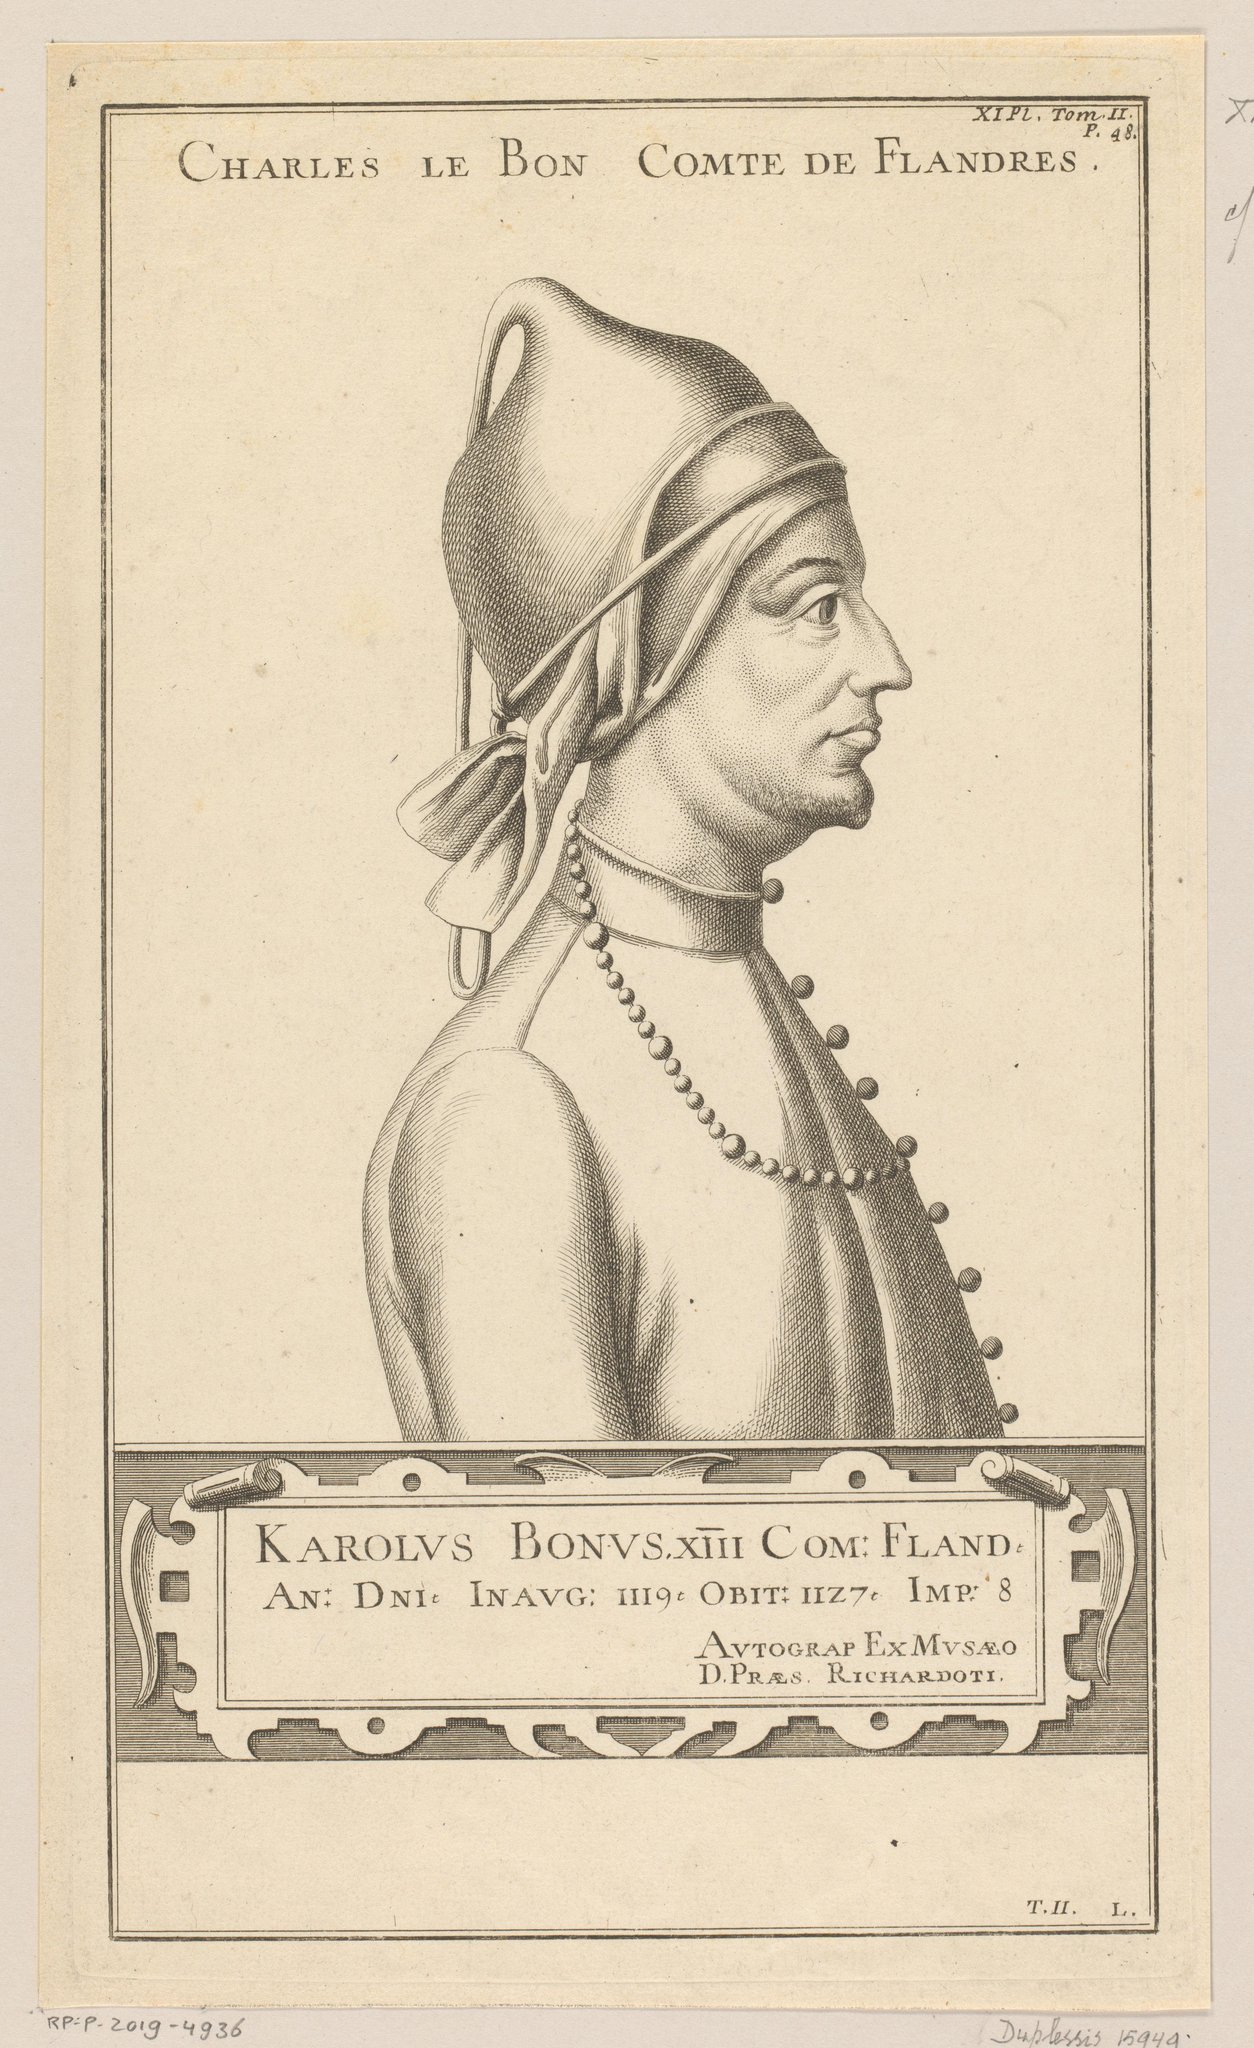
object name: book illustration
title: Portret van Karel de Goede, graaf van Vlaanderen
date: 1730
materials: paper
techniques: engraving, etching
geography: paris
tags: denmark, bruges, earl, historical persons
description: Prent uit: Montfaucon, Bernard de. Les monumens de la Monarchie Françoise (...). Parijs: Julien-Michel Gandouin en Pierre-François Giffart, 1730, dl. 2.